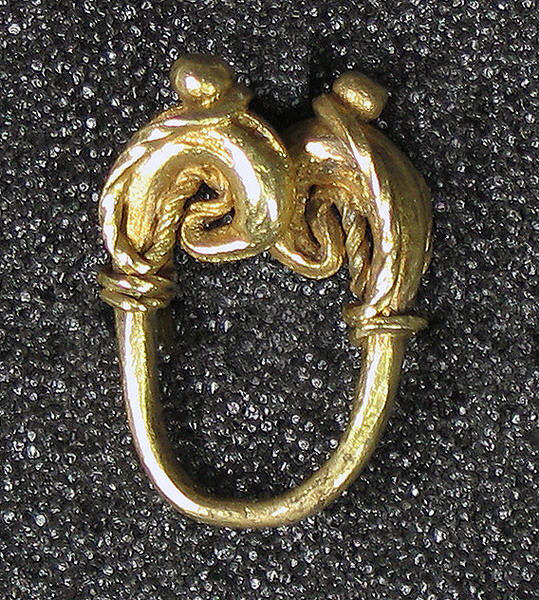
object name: earring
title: Double Scroll Fertility Earring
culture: indonesian, central java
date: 701-1200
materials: gold